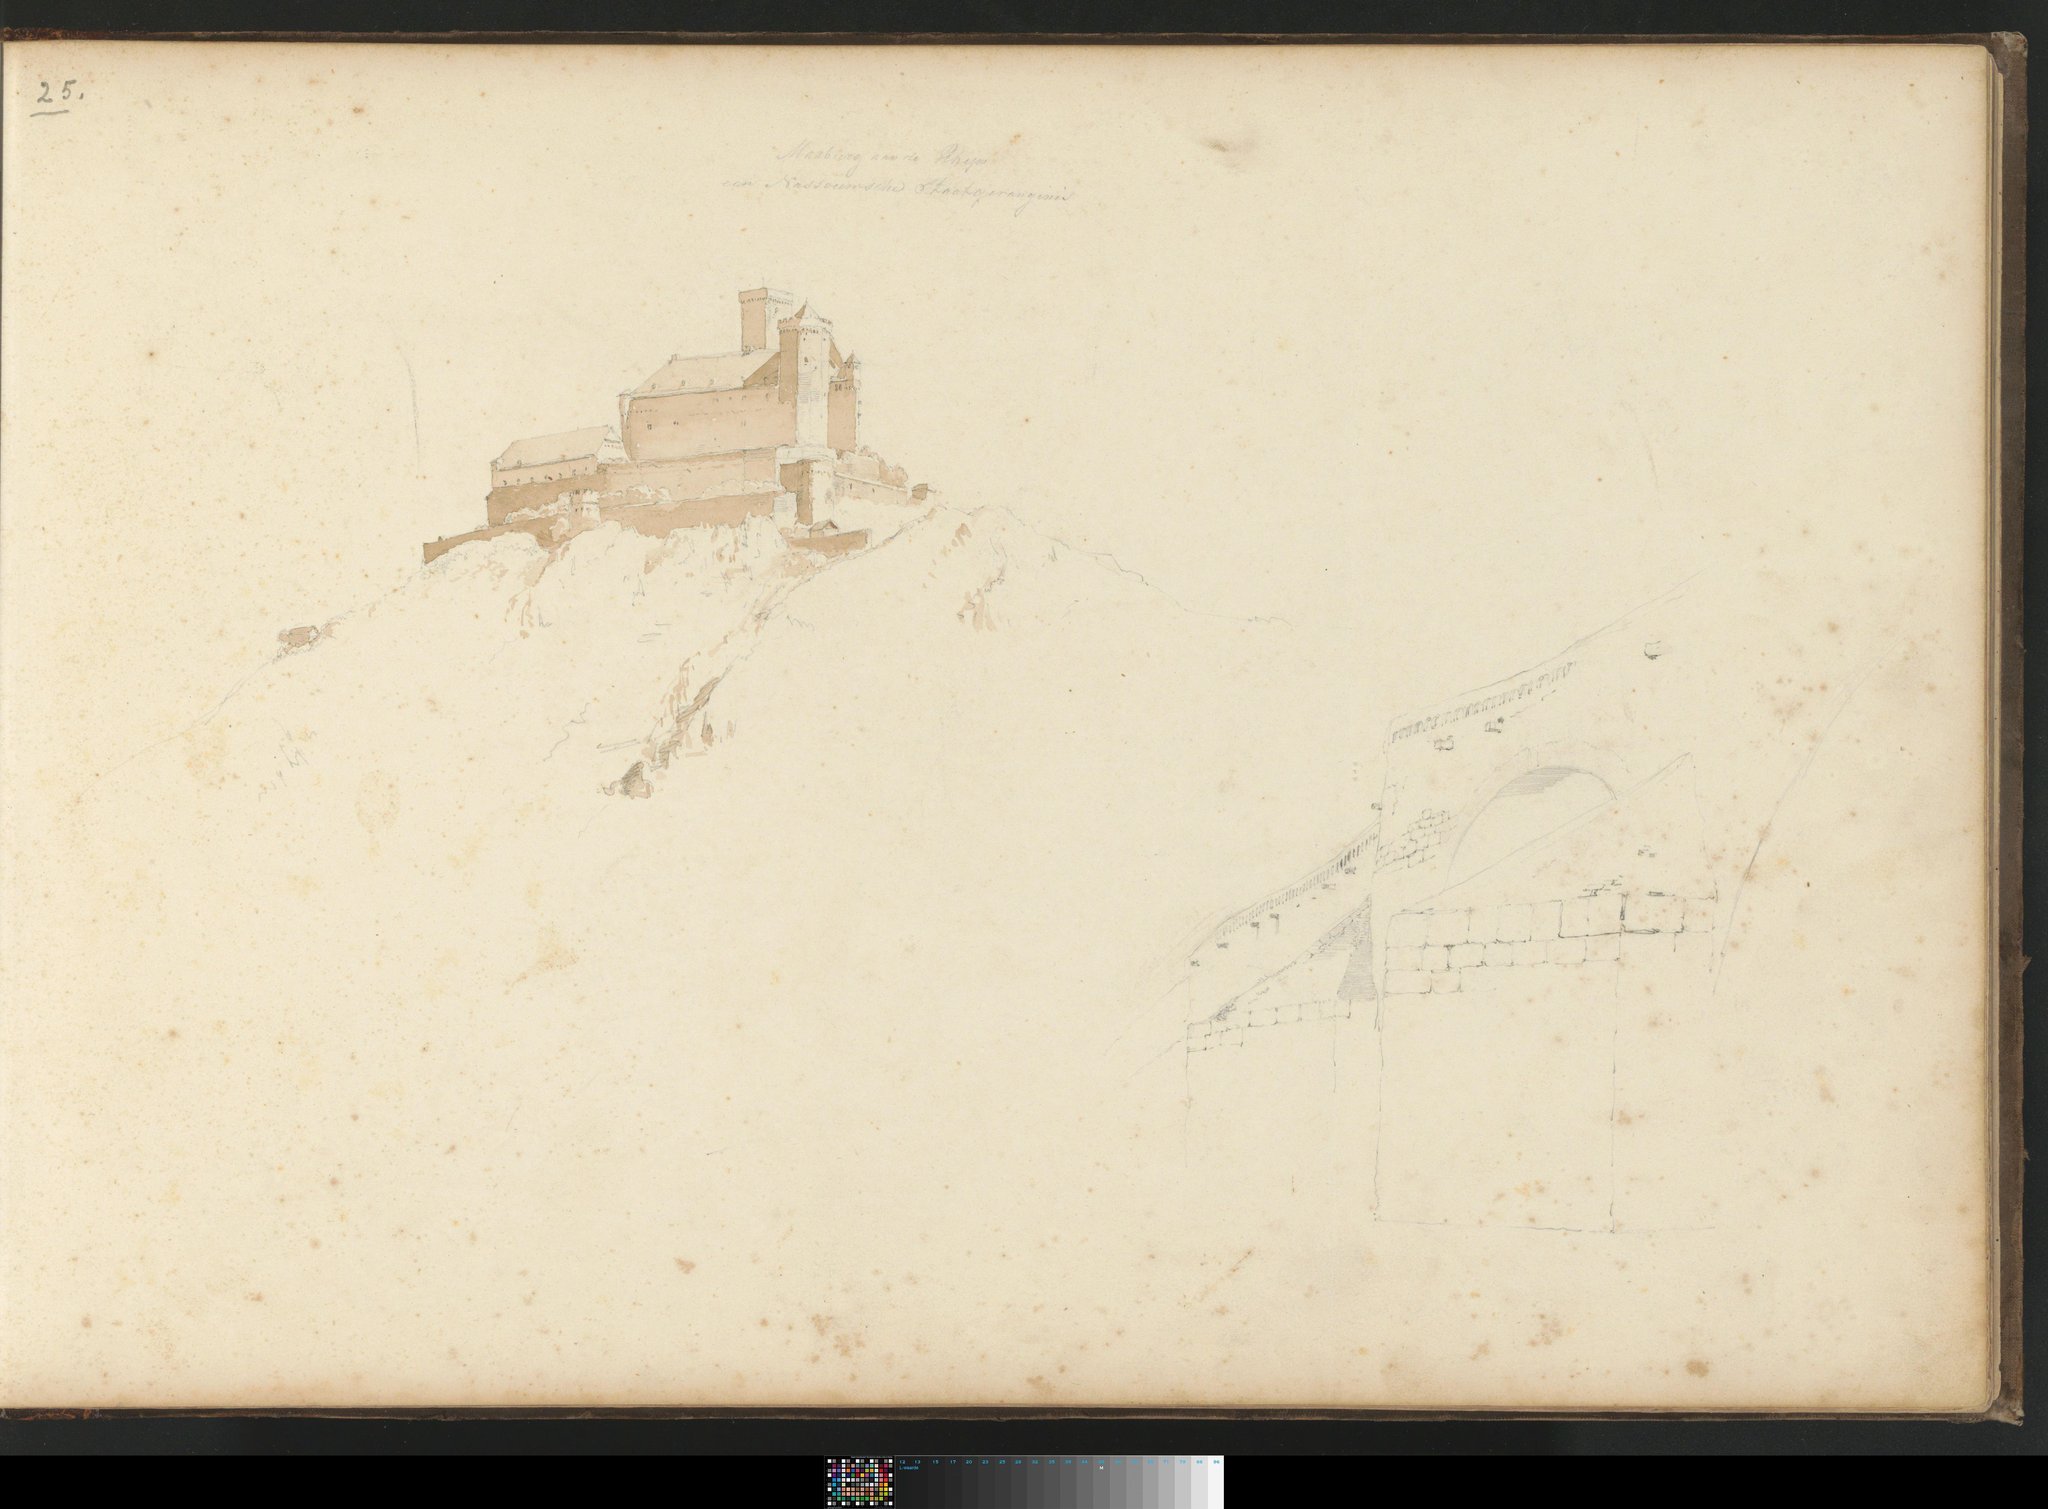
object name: sketchbook leaf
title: Slot op een heuvel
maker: kasparus karsen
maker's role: draughtsman, painter, print maker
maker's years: 1810-1896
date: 1820-1896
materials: paper, pencil, watercolor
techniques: brush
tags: castle, walls ~ fortified city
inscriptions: annotation: ‘[...]arburg aan de Rhijn/ een nassausche staatsgevangenis’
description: Tevens een studie van een verdedigingsmuur. Blad 25 recto uit een schetsboek met 68 bladen.